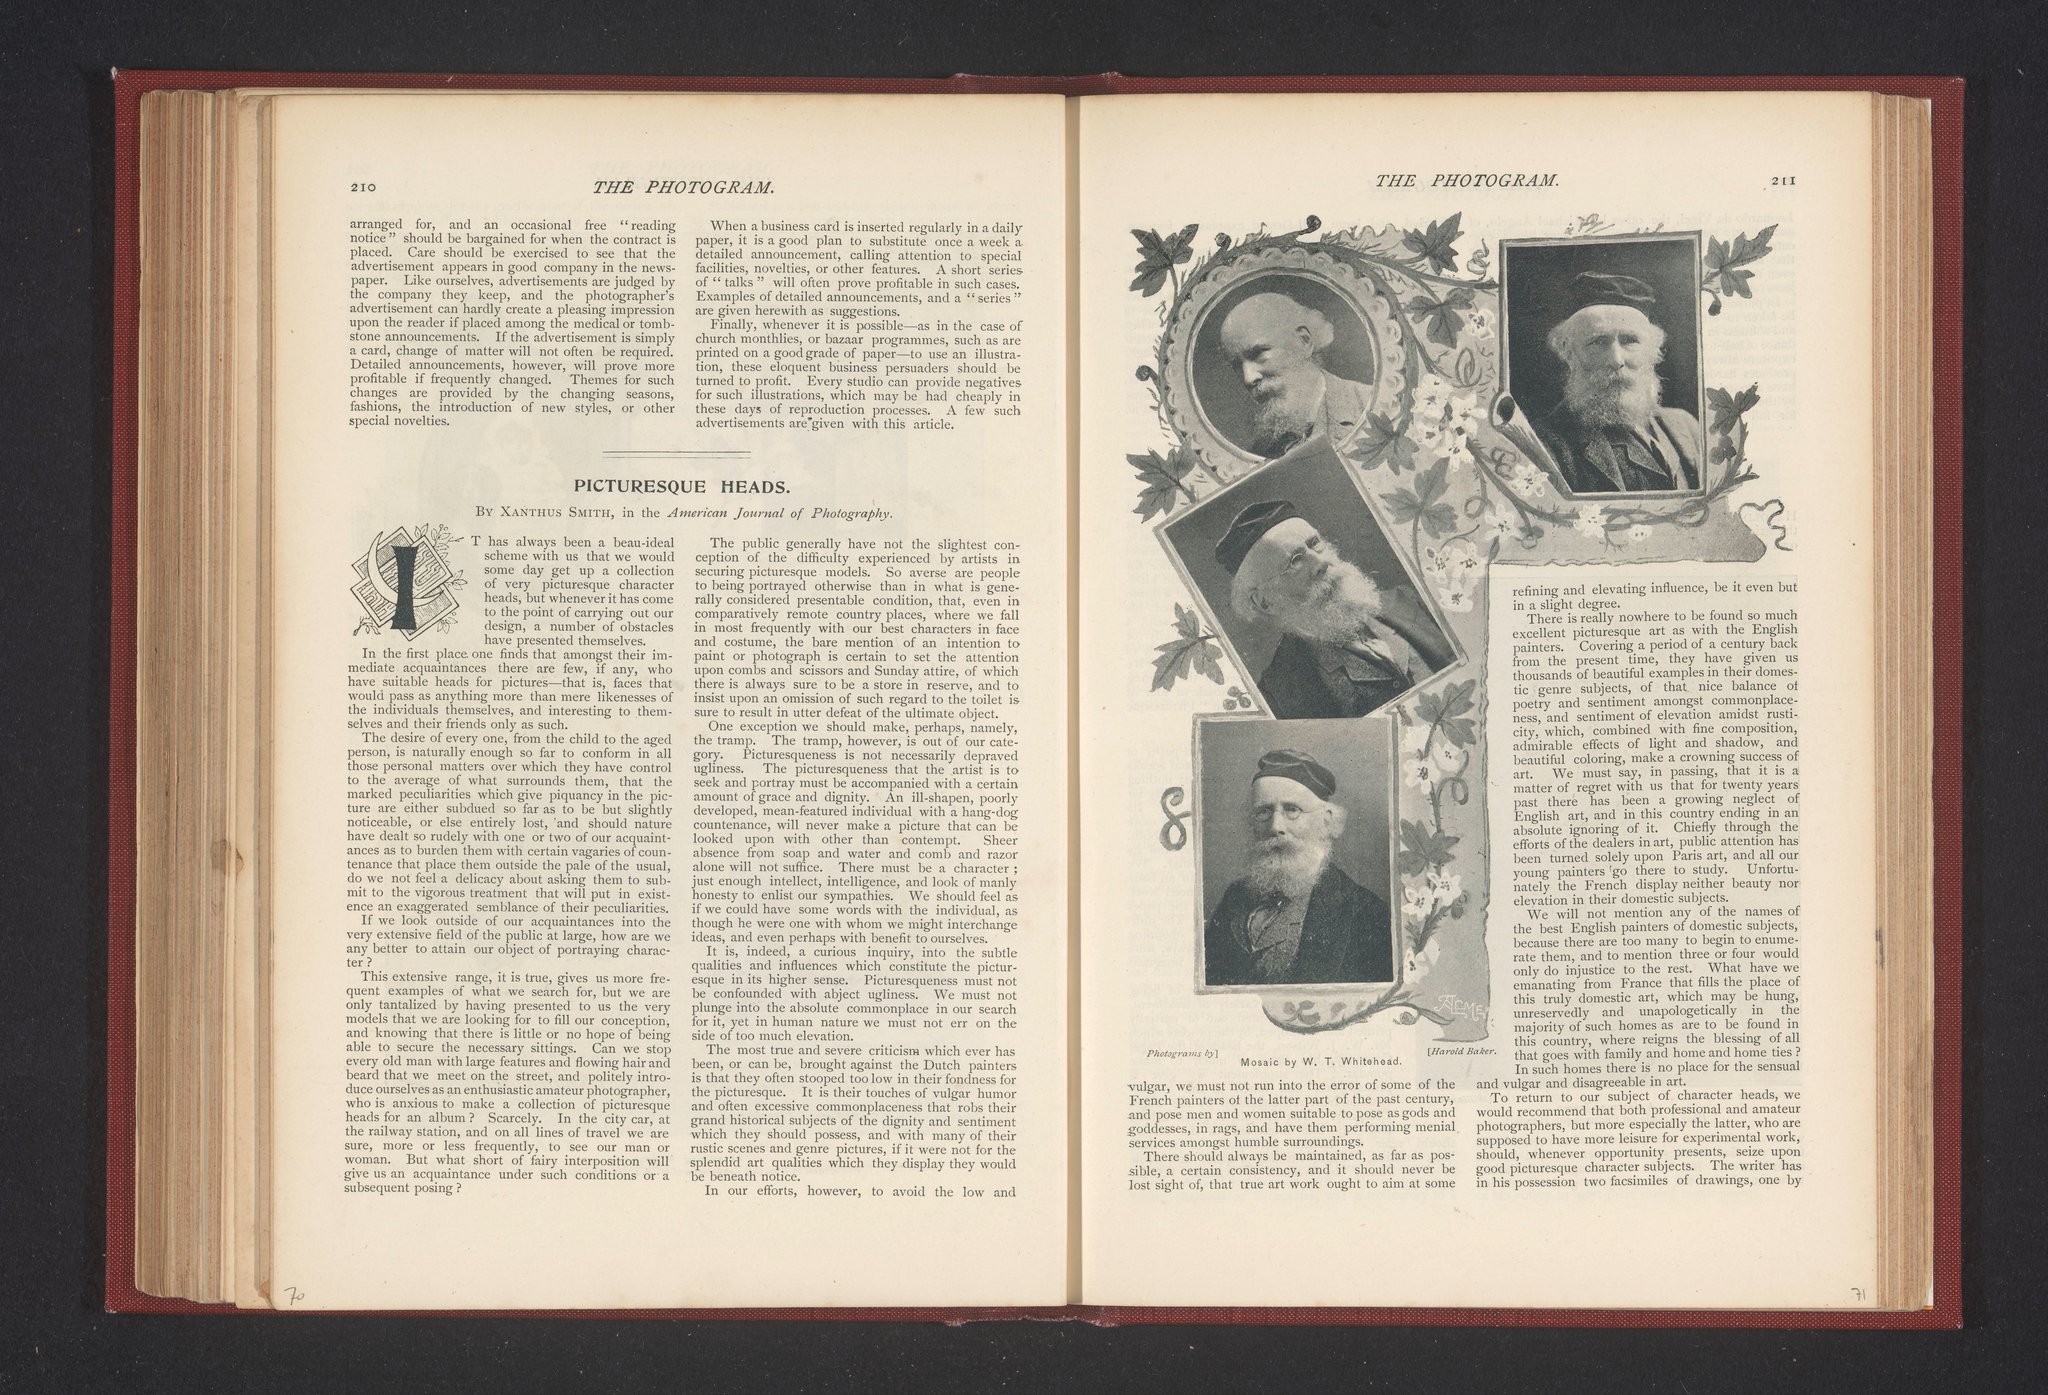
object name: photomontage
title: Fotomontage van vier portretten van onbekende mannen met een illustratie door W.T. Whitehead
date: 1889-1894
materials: paper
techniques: autotype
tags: historical persons